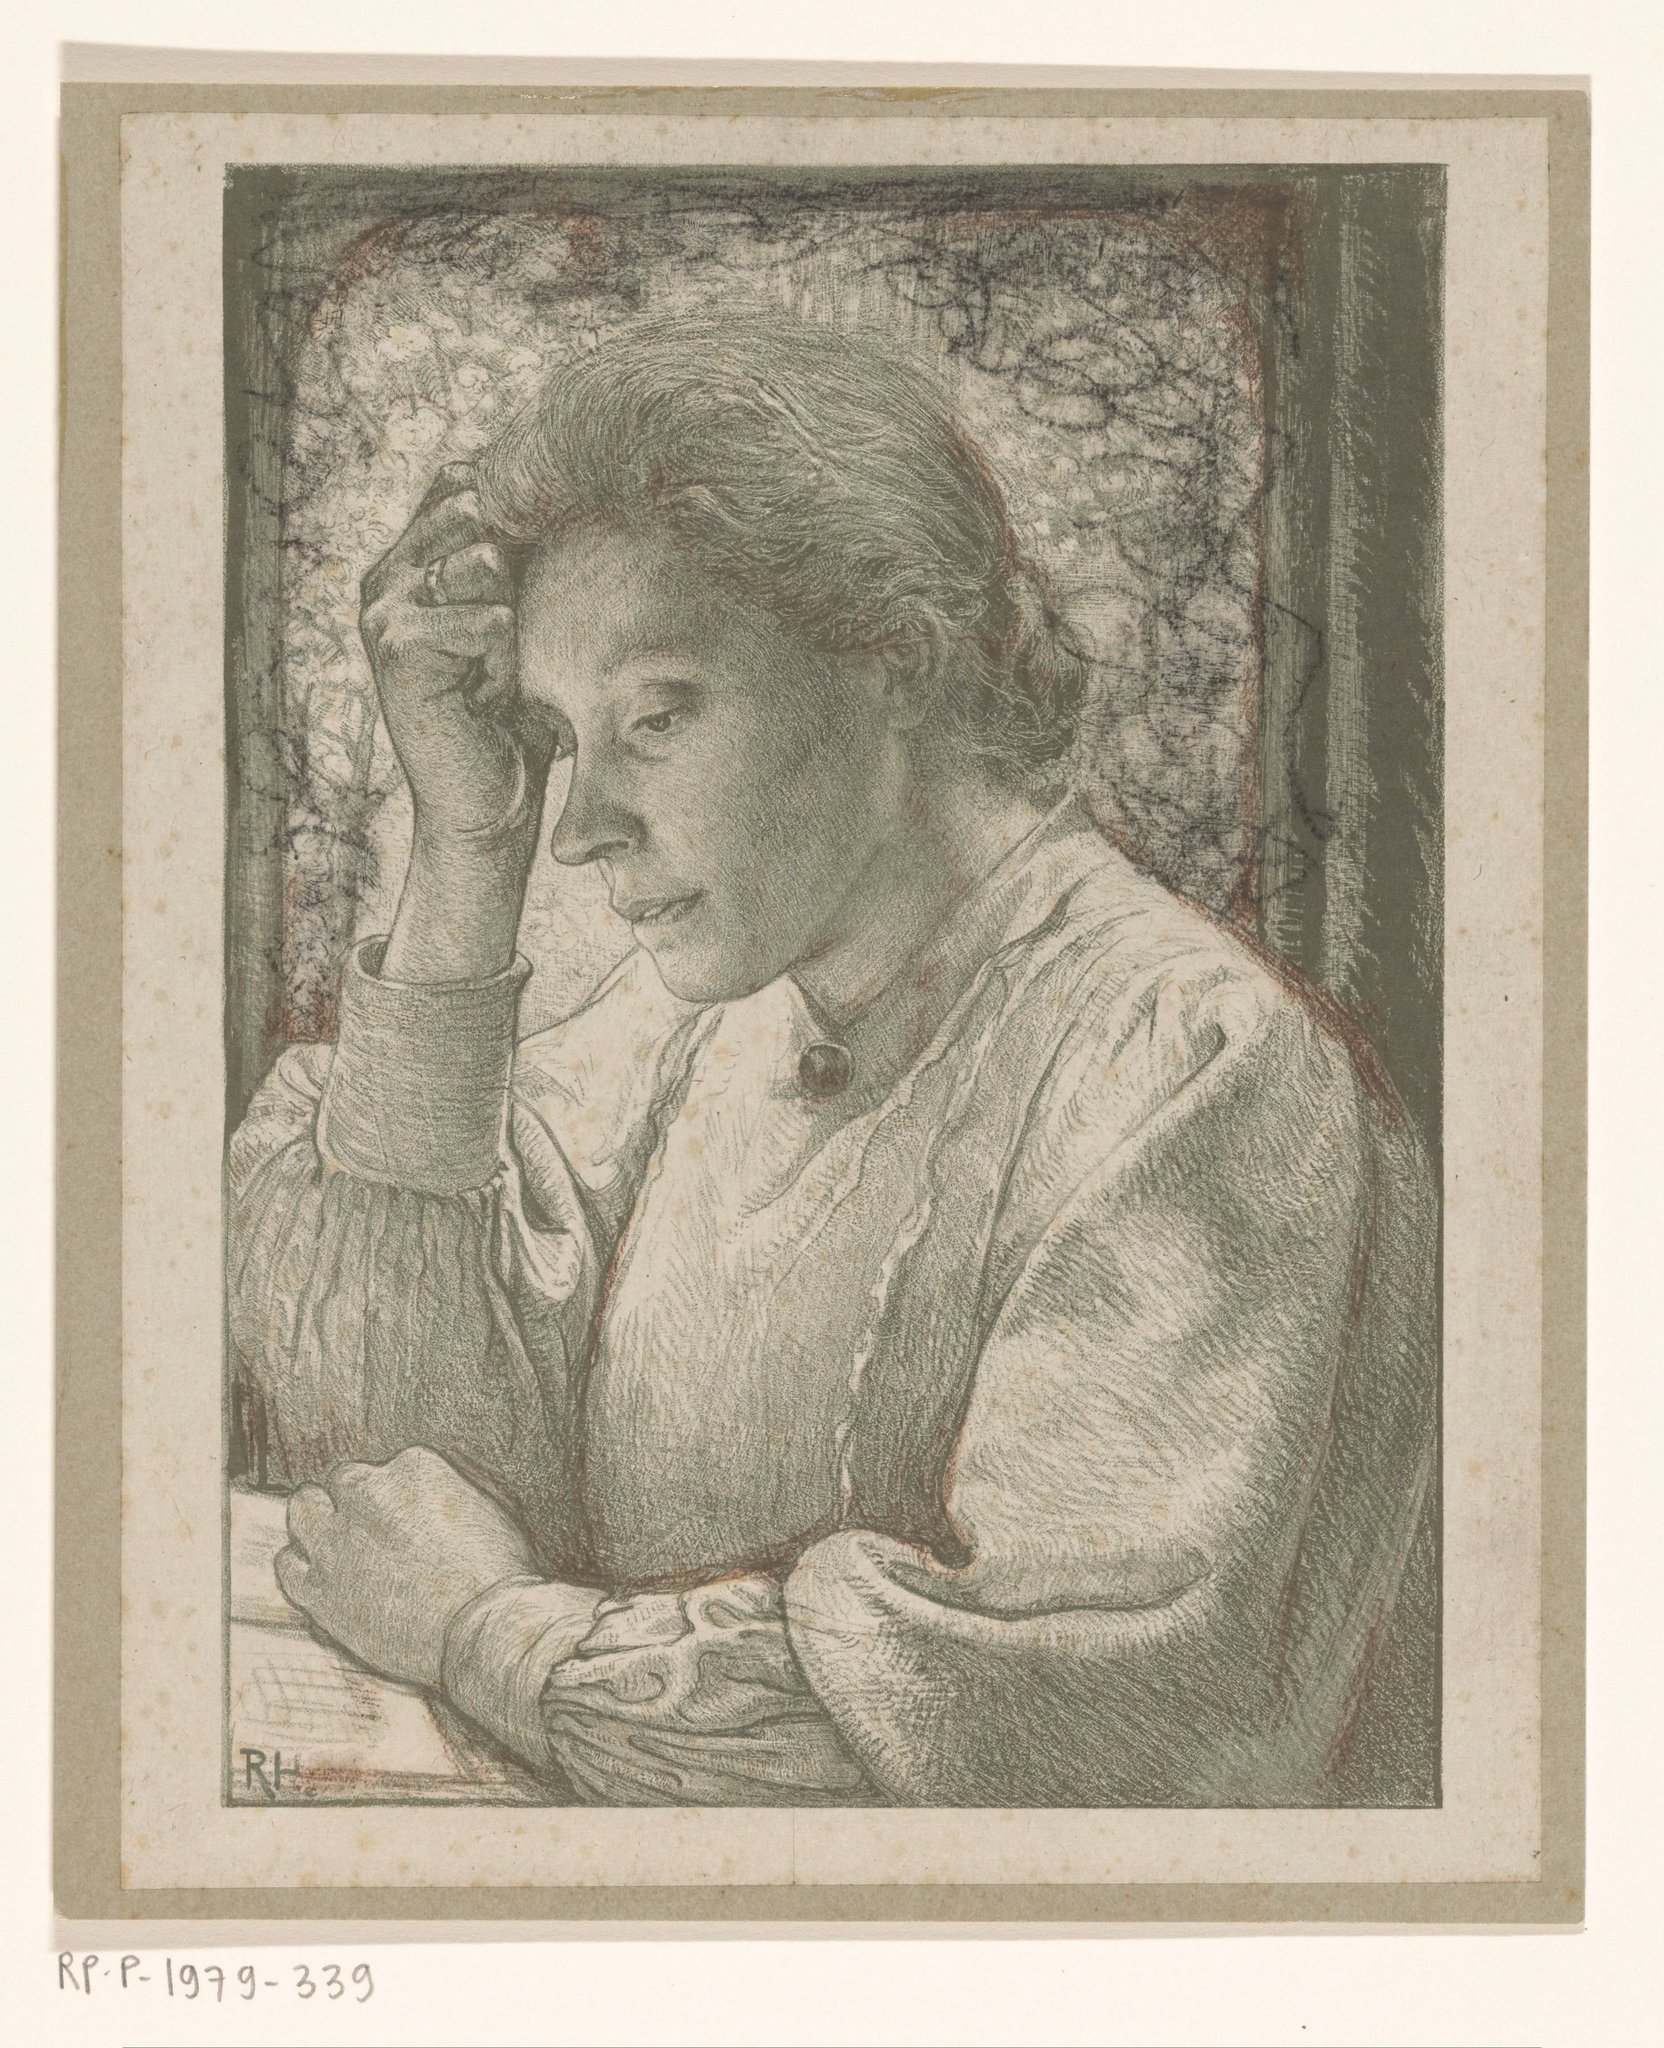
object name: print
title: Portret van Henriëtte Roland Holst-van der Schalk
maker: richard nicolaüs roland holst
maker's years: 1868-1938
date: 1898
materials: chalk, paper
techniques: lithograph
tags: henriëtte roland holst-van der schalk, reading, historical persons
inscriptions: collector's mark: Lugt 2228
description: Een portret van Henriëtte Roland Holst-van der Schalk, die een boek leest en haar hoofd met haar hand ondersteunt.